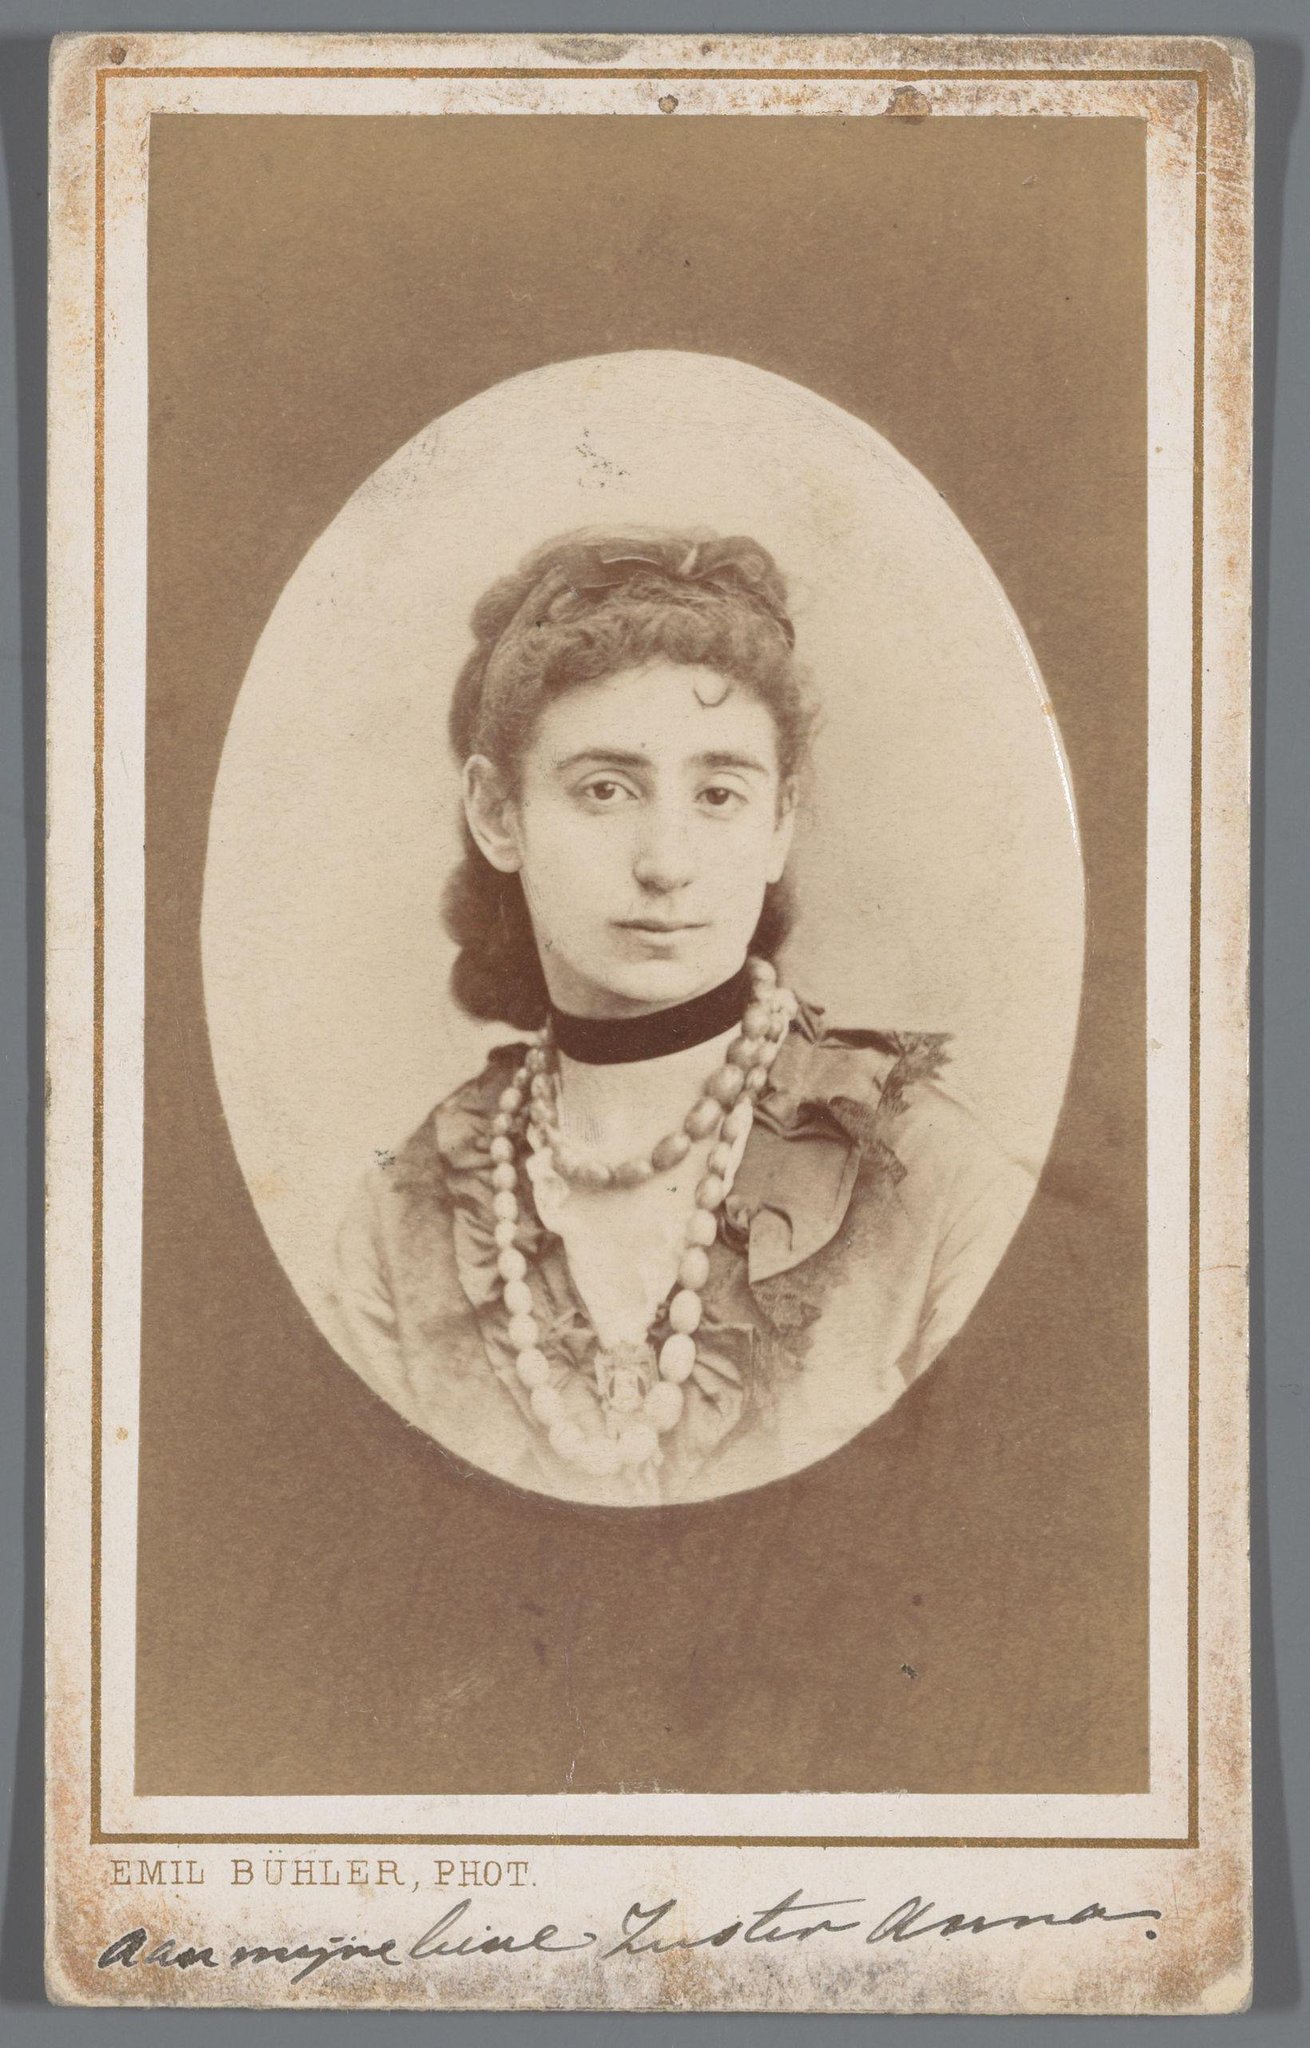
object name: carte de visite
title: Portret van een onbekende jonge vrouw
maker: emil bühler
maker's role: fotograaf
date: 1855-1885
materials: cardboard, paper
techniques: albumen print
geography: mannheim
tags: adolescent, young woman, maiden, anonymous historical person portrayed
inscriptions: monogram: ‘EB’, inscription: ‘Emil Bühler/ Photograph/ B7 No 1, Ludwigs-Strasse No 34/ am Schlossgarten/ Mannheim./ No.../ Die Originalplatte bleibt zum/ Nachbestellen aufbewahrt.’, inscription: ‘Emil Bühler, phot.’, inscription: ‘Aan mijn lieve zuster Anna.’